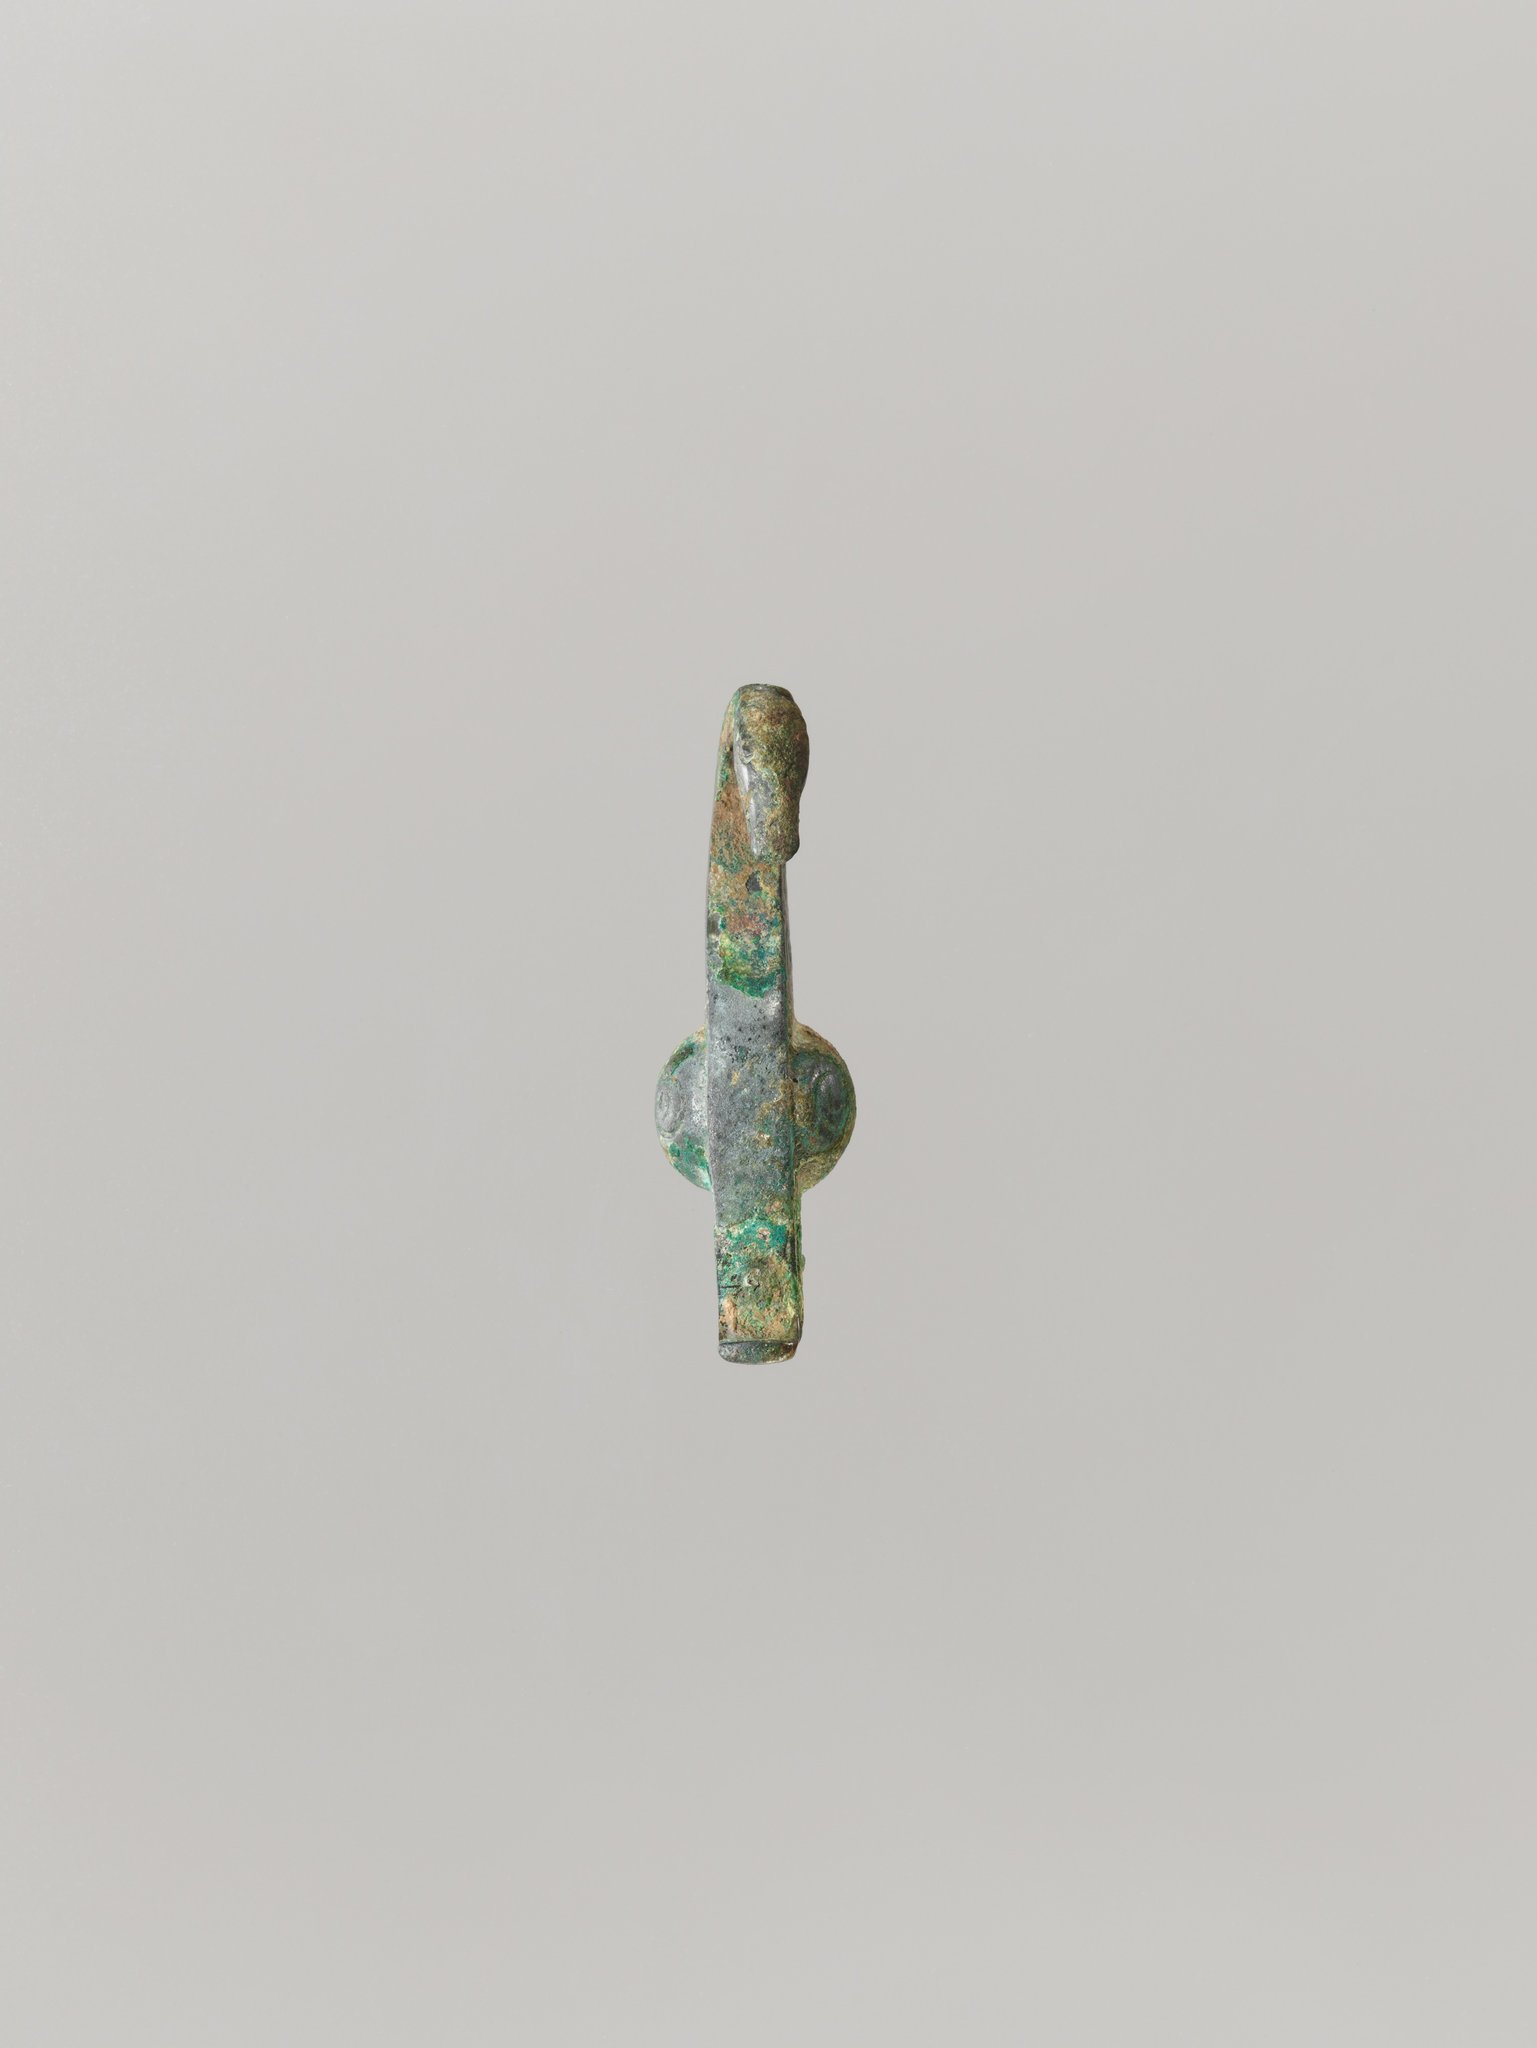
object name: belt hook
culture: chinese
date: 500-301 BCE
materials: bronze